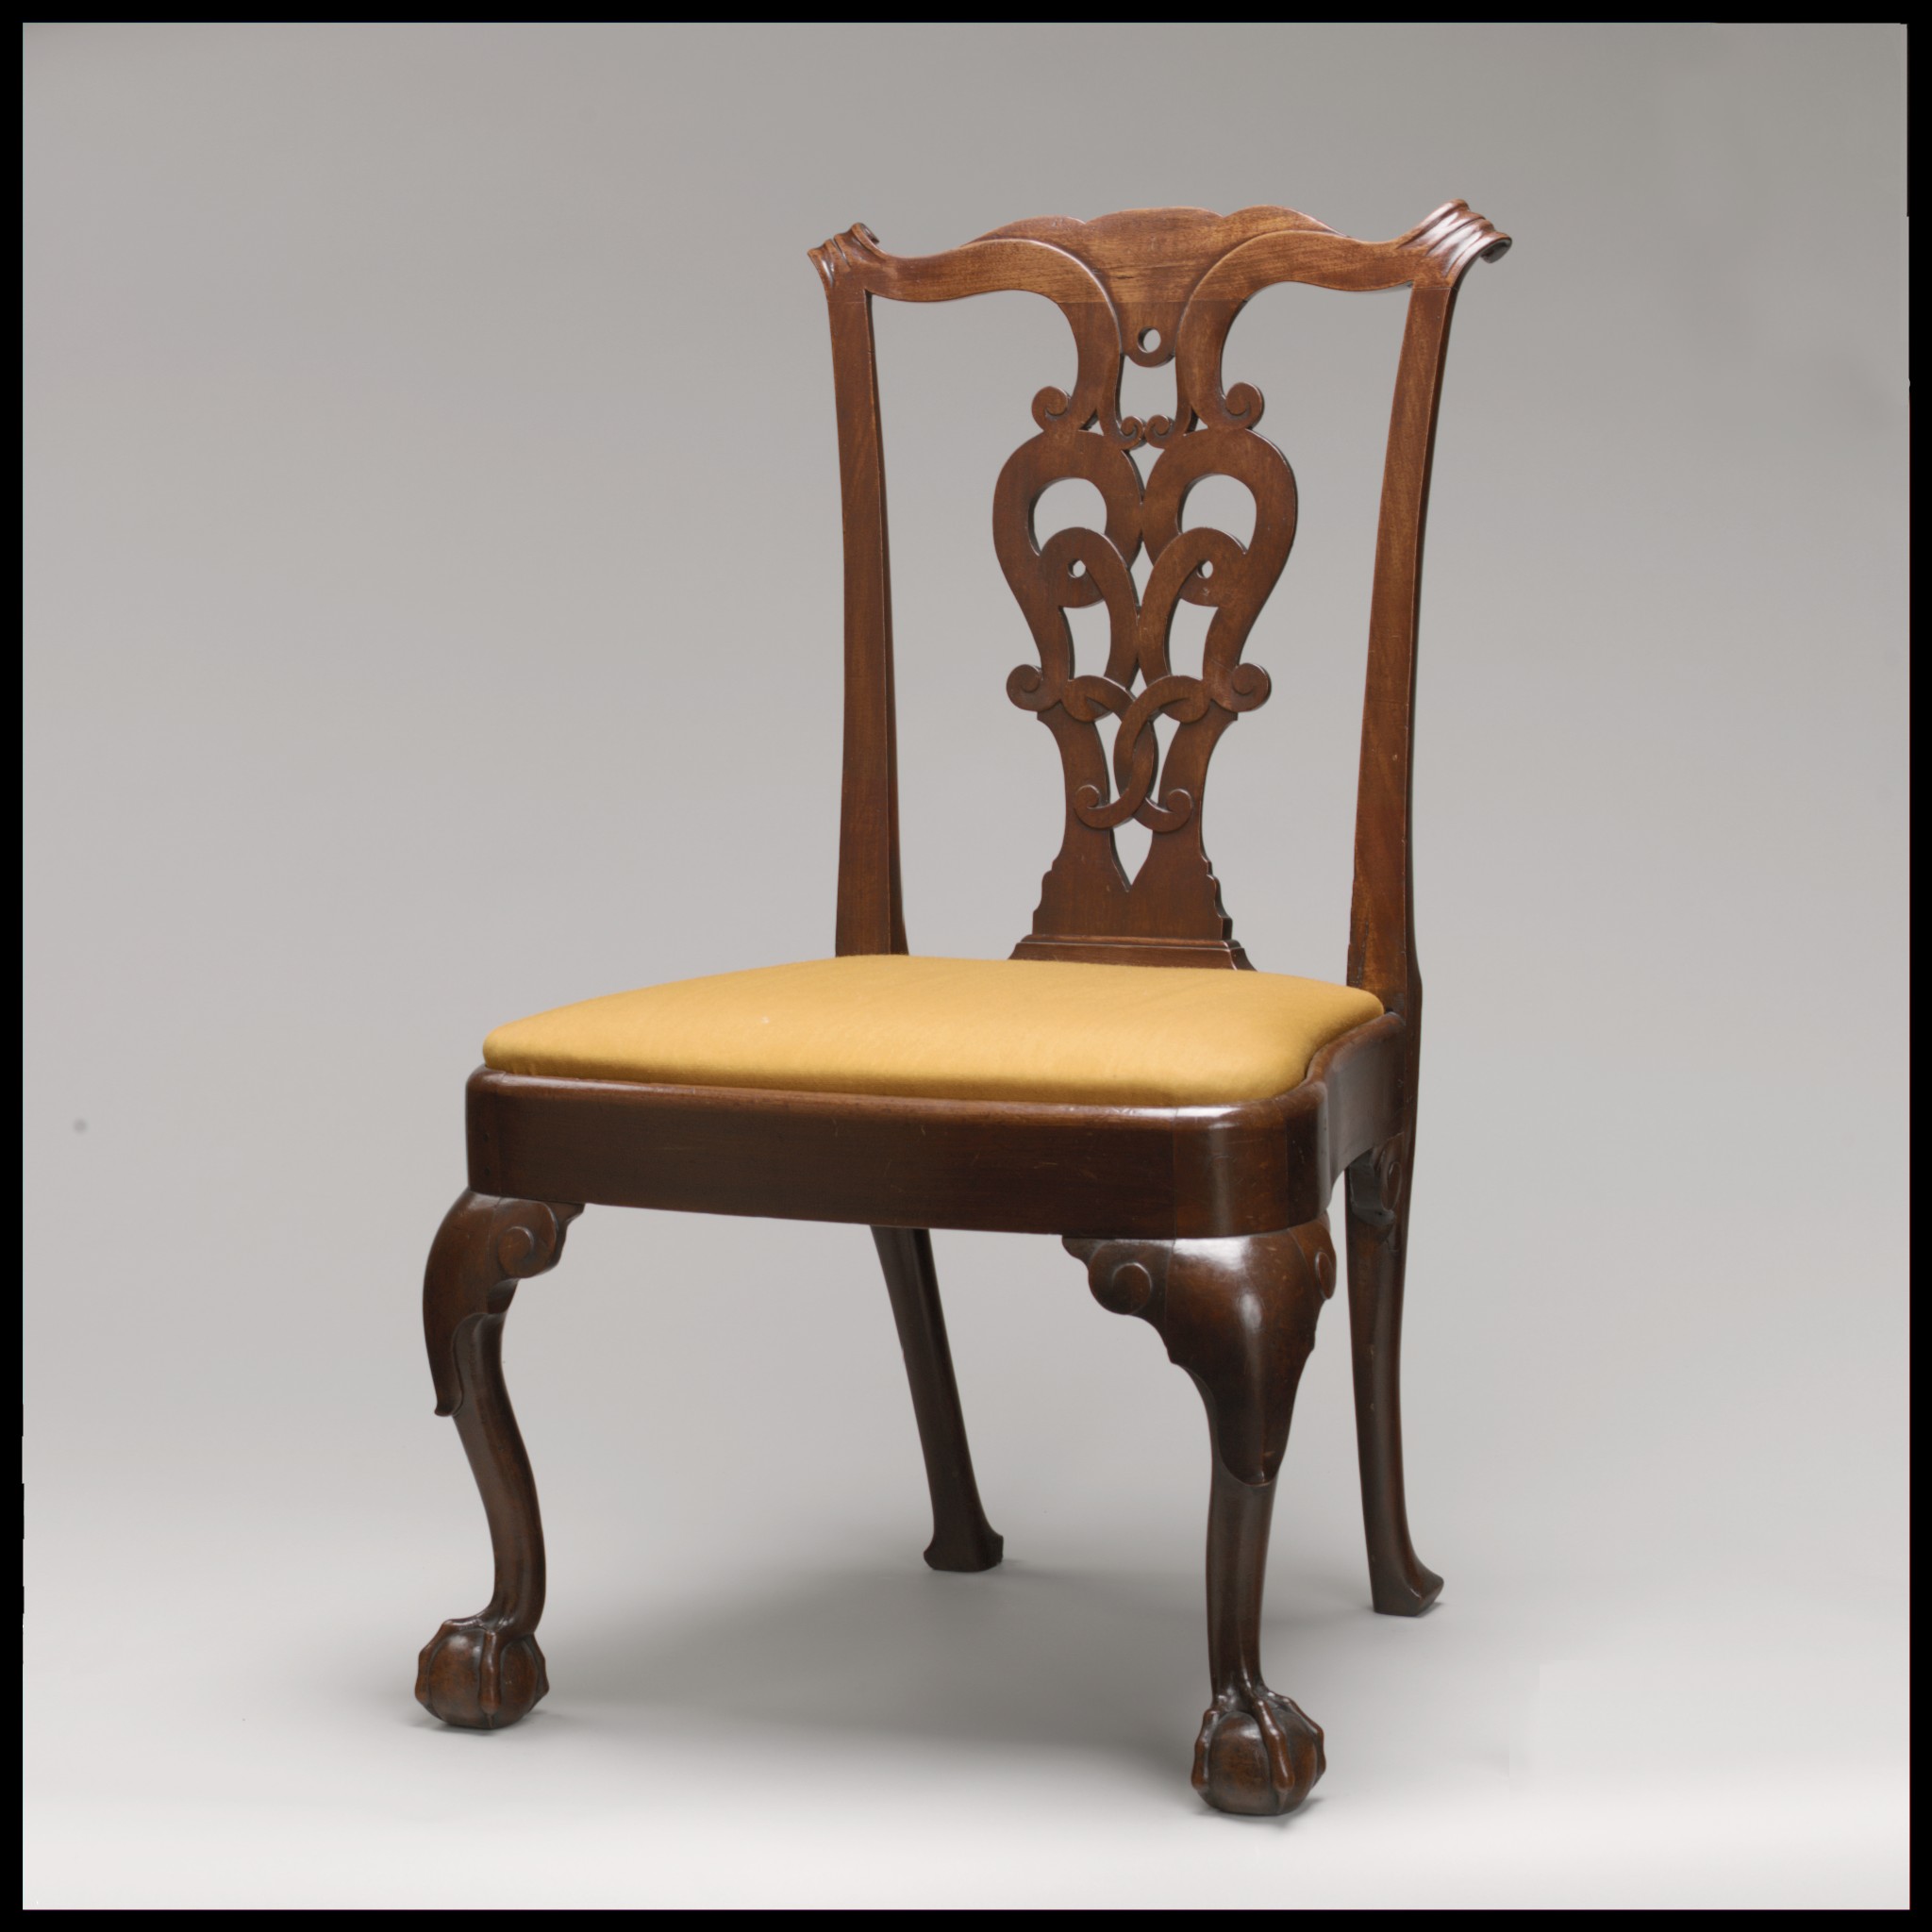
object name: side chair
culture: american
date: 1760-1790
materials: wood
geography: united states